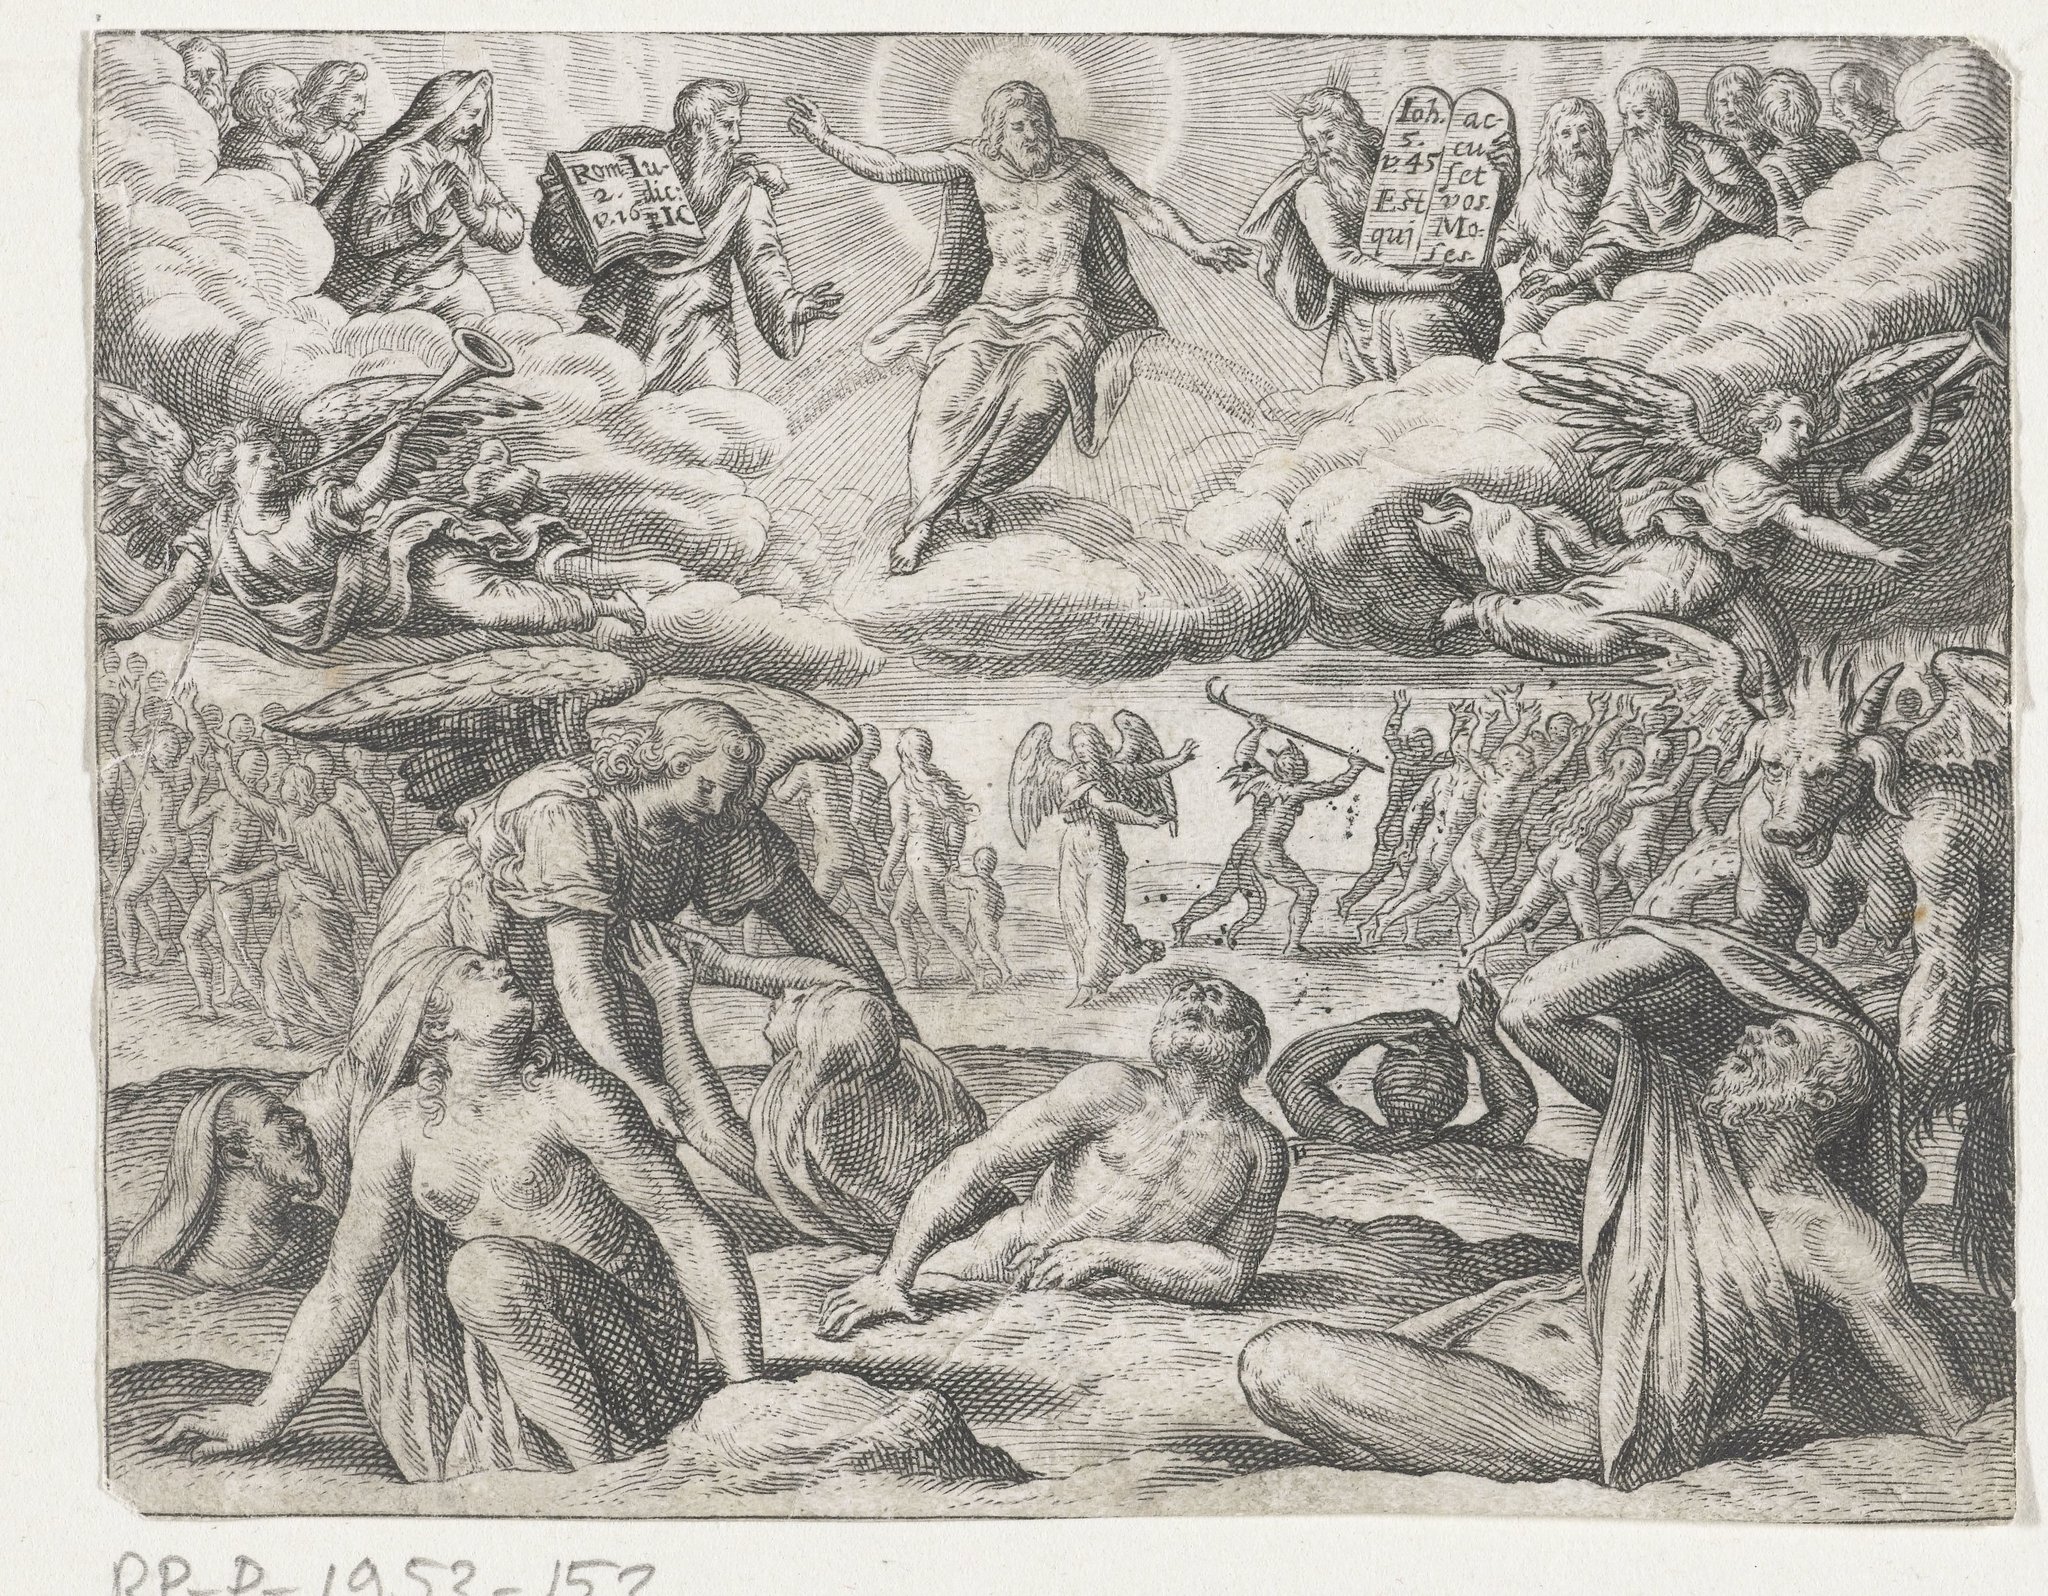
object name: print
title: Laatste Oordeel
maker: johann theodor de bry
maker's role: print maker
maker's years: 1561-1623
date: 1611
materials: paper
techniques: engraving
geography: oppenheim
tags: last judgement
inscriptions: collector's mark: Lugt 1606, collector's mark: Lugt 2228, collector's mark: Lugt 2398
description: Afkomstig uit: J.T. de Bry, Emblemata saecularia varietate seculi huius mores ita experimentia (...). 2e druk. Oppenheim: gedrukt bij Hieronymus Galler, 1611. De compositie is overgenomen van een gravure van Johannes Sadeler (Hol.452) naar Dirck Barentsz. De Bry heeft enkele veranderingen aangebracht en sommige figuren overgenomen van Het Laatste Oordeel van Johannes Sadeler naar Maerten de Vos (Hollstein Dutch 471).